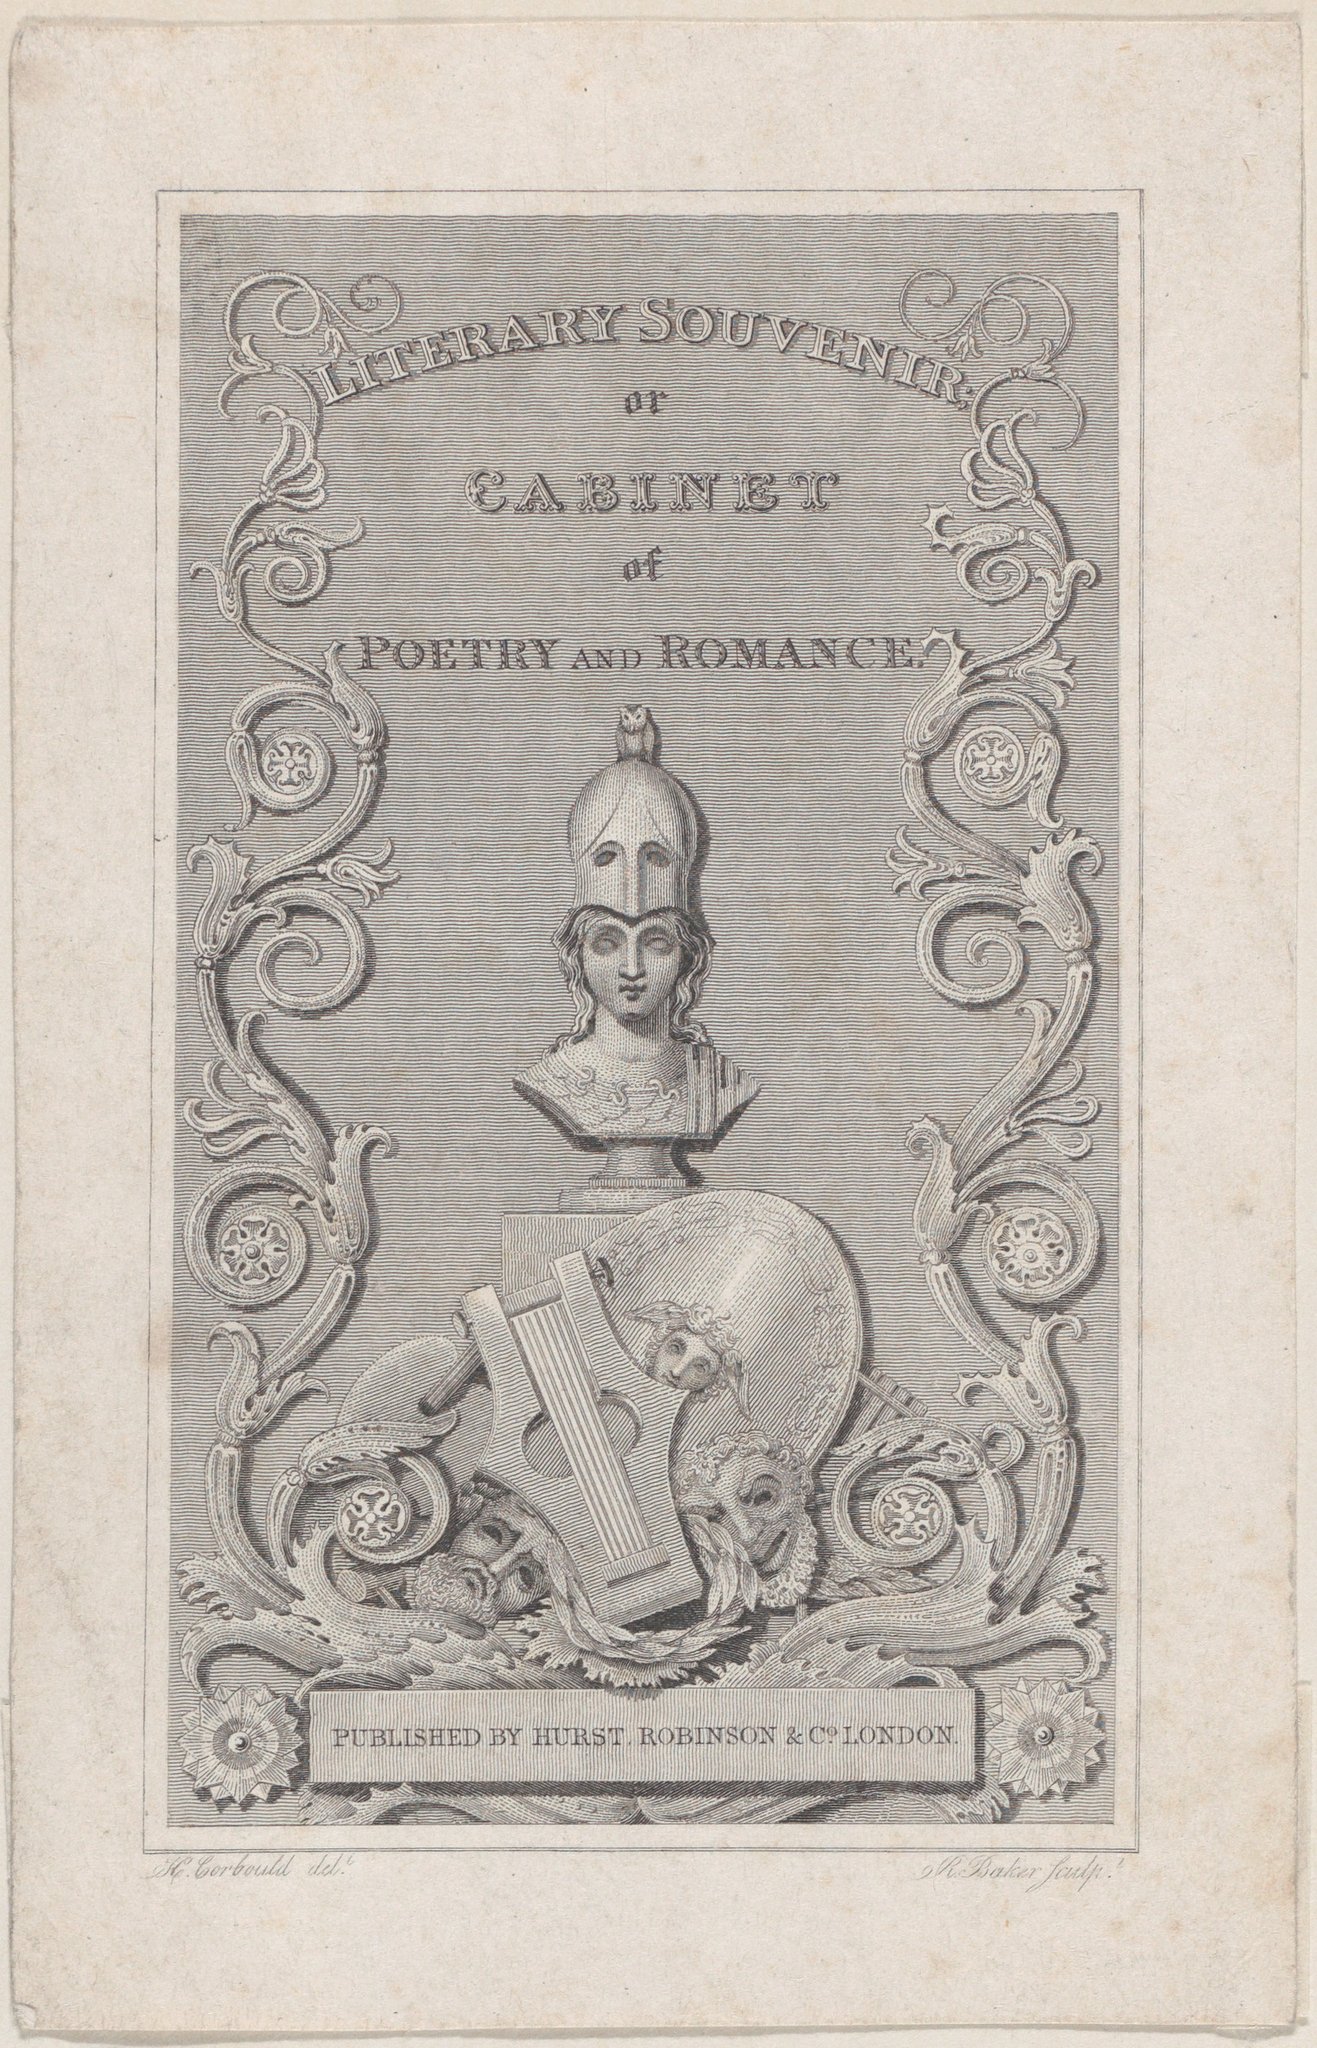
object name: print, trade card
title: Trade Card for Literary Souvenir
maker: robert baker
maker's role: artist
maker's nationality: british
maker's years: 1793-1858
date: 1801-1900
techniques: engraving